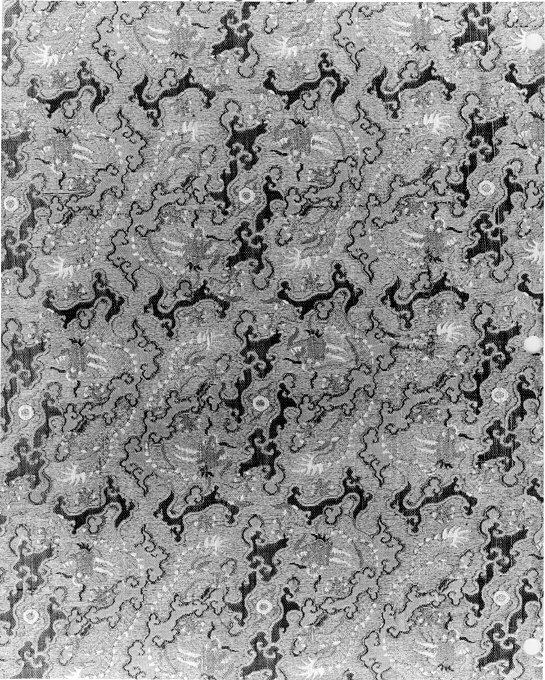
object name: length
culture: chinese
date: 1867-1900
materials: metal thread, silk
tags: dragons